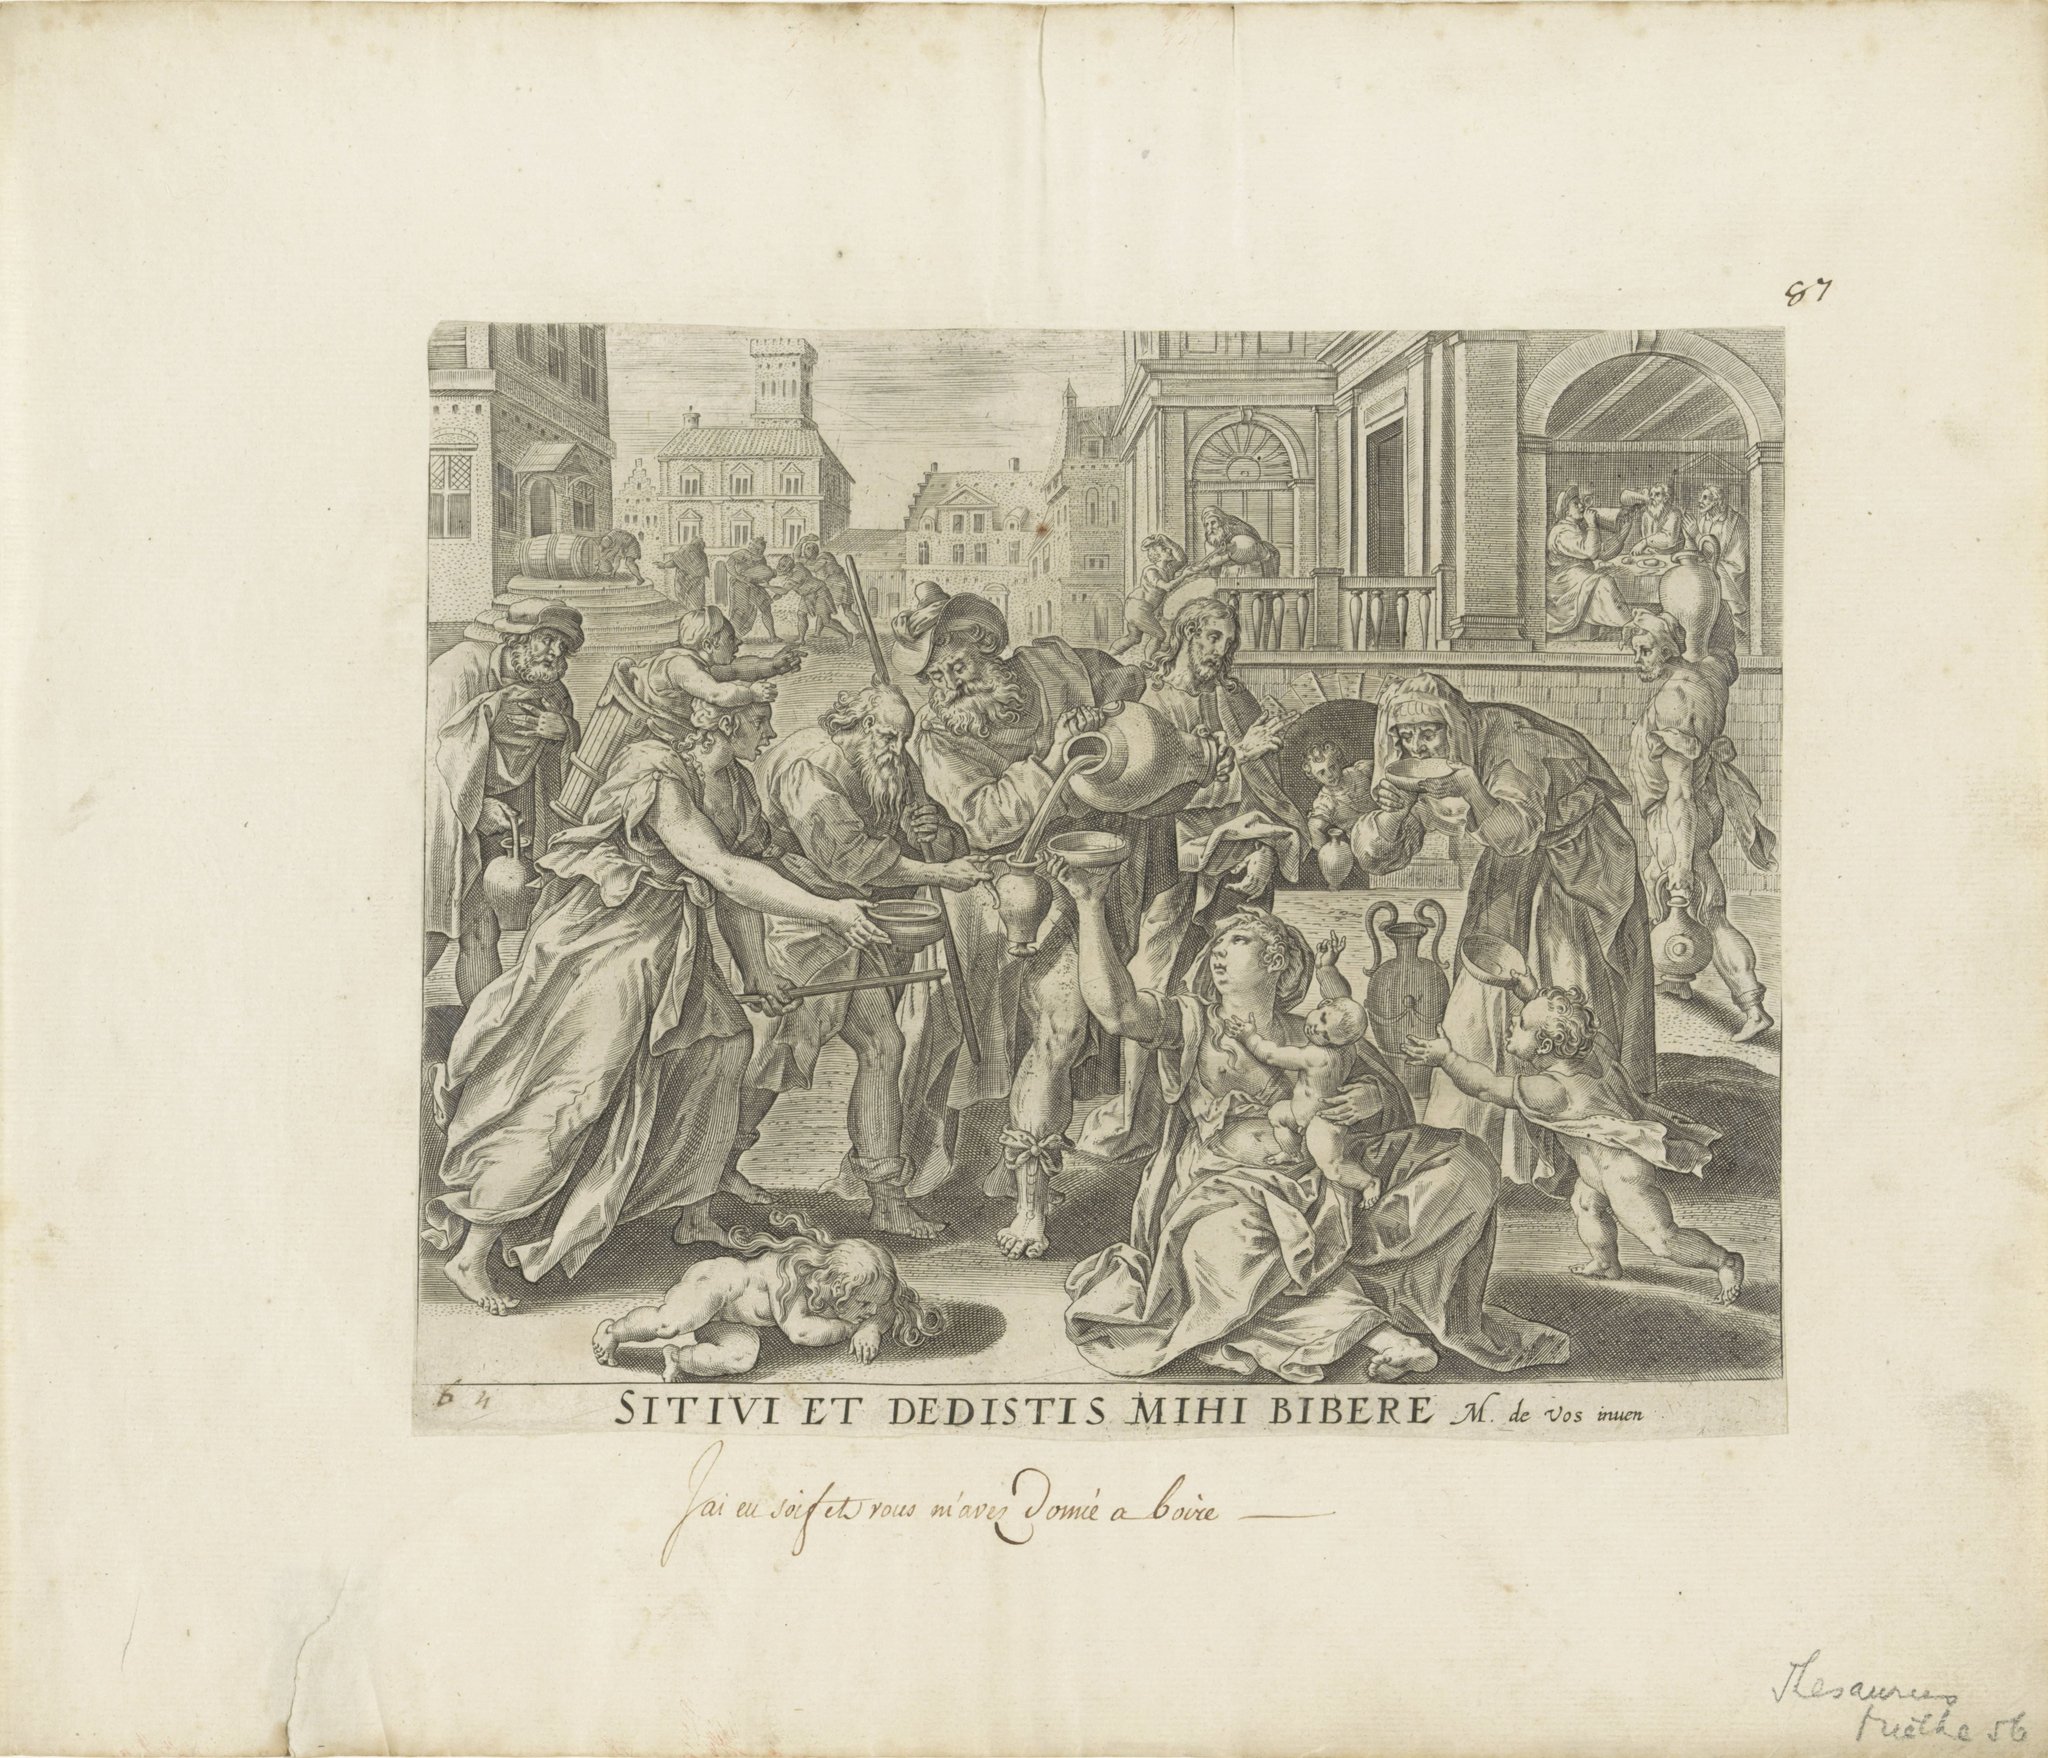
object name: print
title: Thesaurus sacrarum historiarum veteris testamenti (...)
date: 1585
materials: paper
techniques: engraving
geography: antwerp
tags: giving the thirsty to drink, 'sitiens potatur' ~ one of the (seven) acts of mercy - vv - christ present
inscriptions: collector's mark: Lugt 2228, inscription: ‘Jai eu soif et vous m'avez donné a boire’, number: ‘87’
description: Een man schenkt uit een kruik drinken aan de dorstigen, die kommen en kruiken ophouden. Achter de man staat Christus. Op de achtergrond wordt eveneens drinken uitgedeeld. Onder de voorstelling een verwijzing in het Latijn naar de Bijbeltekst.